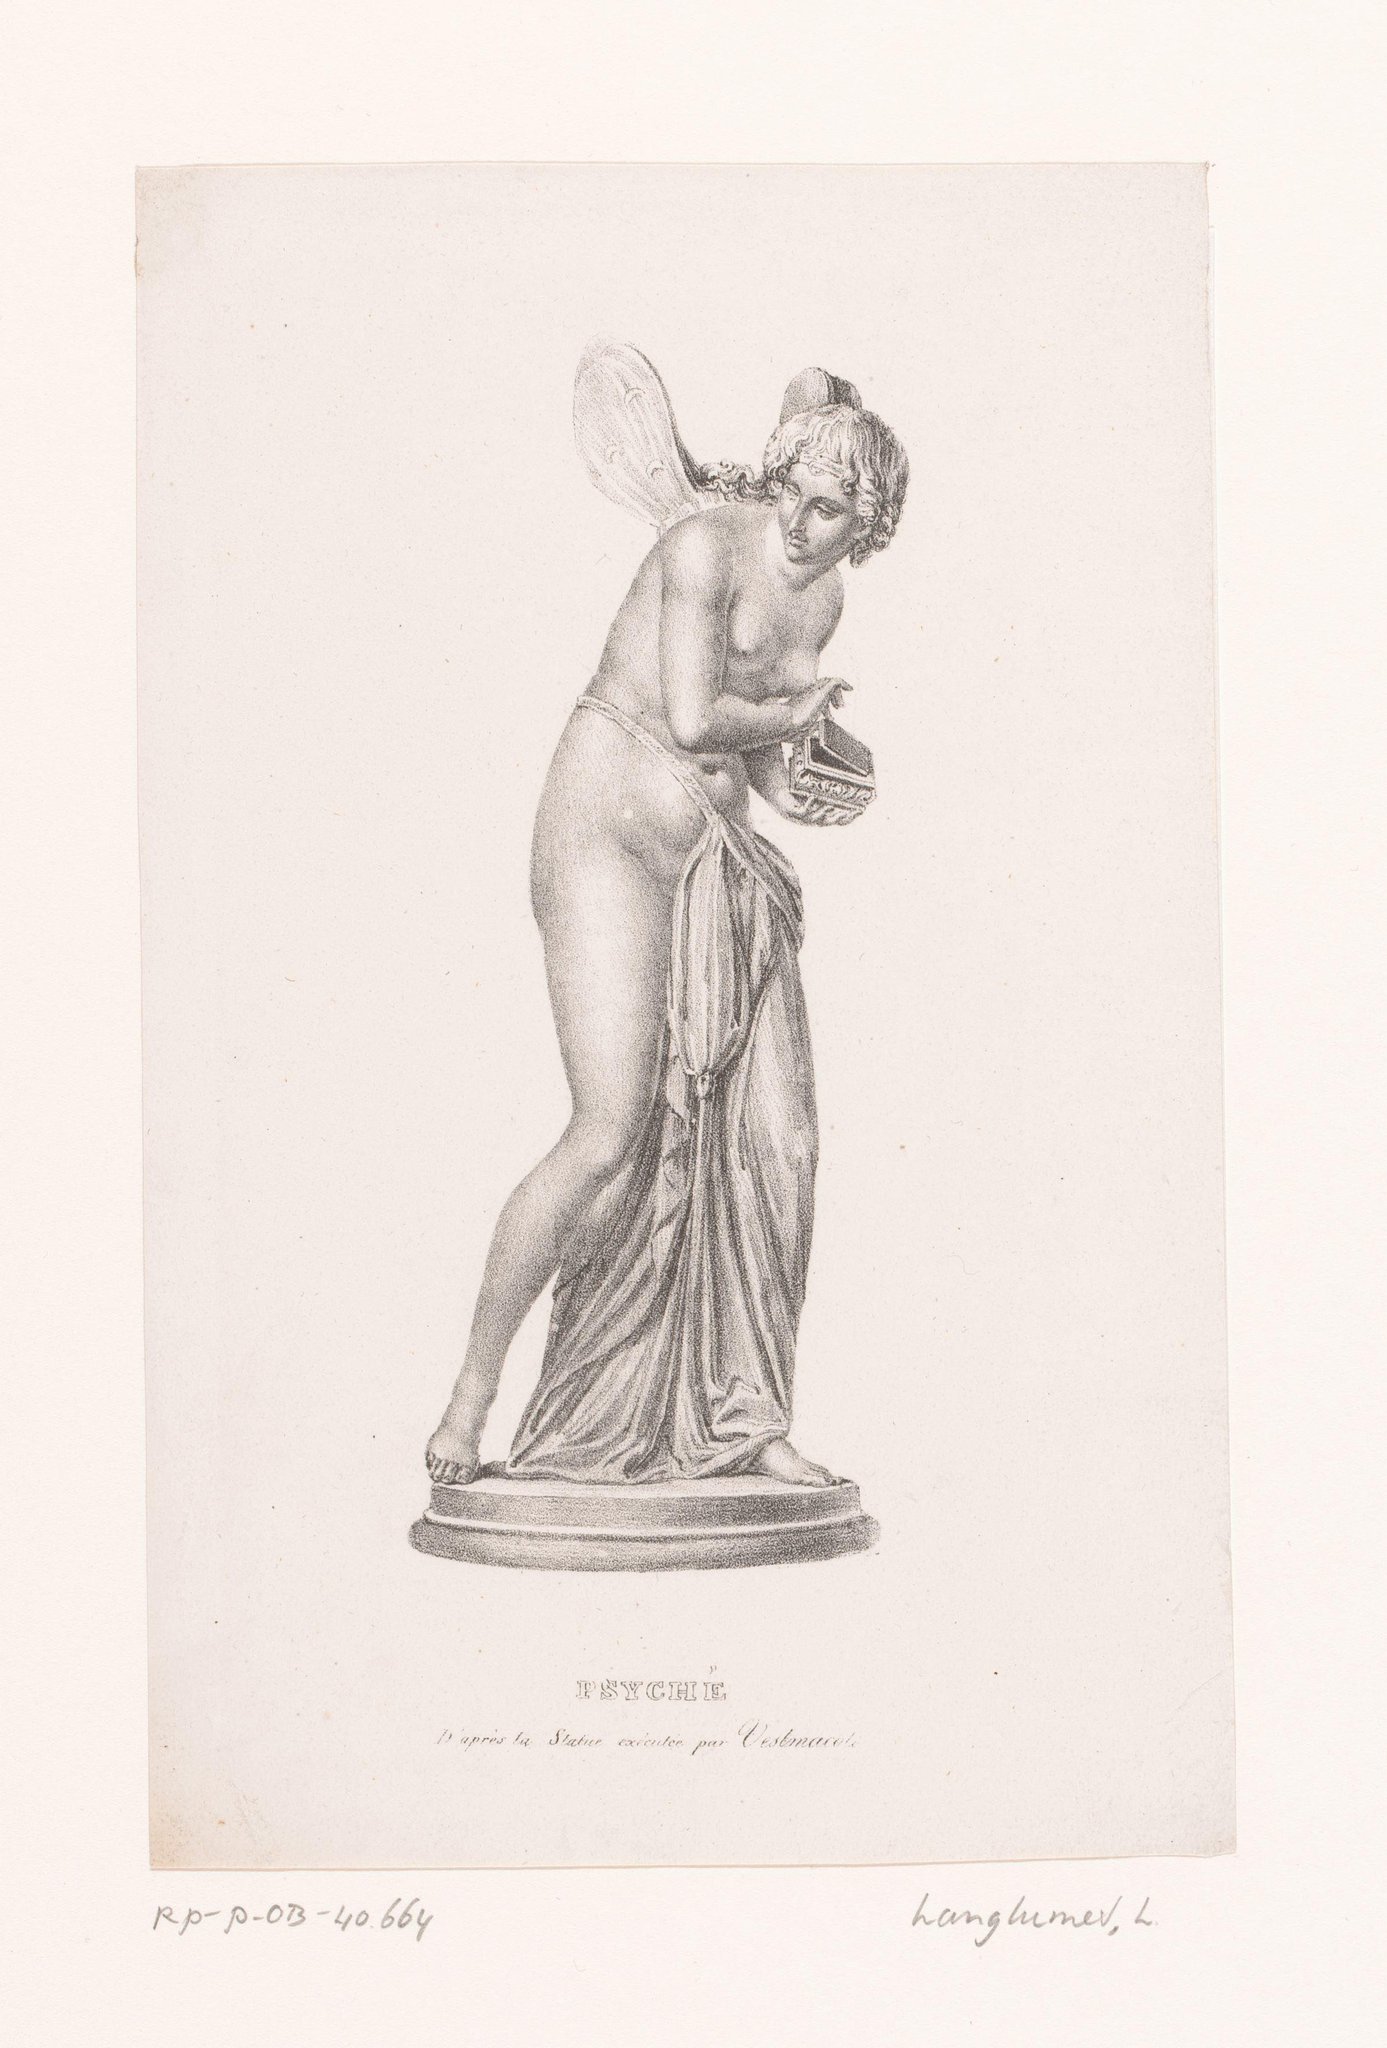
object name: print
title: Psyche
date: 1822-1825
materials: paper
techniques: lithograph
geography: paris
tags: psyche